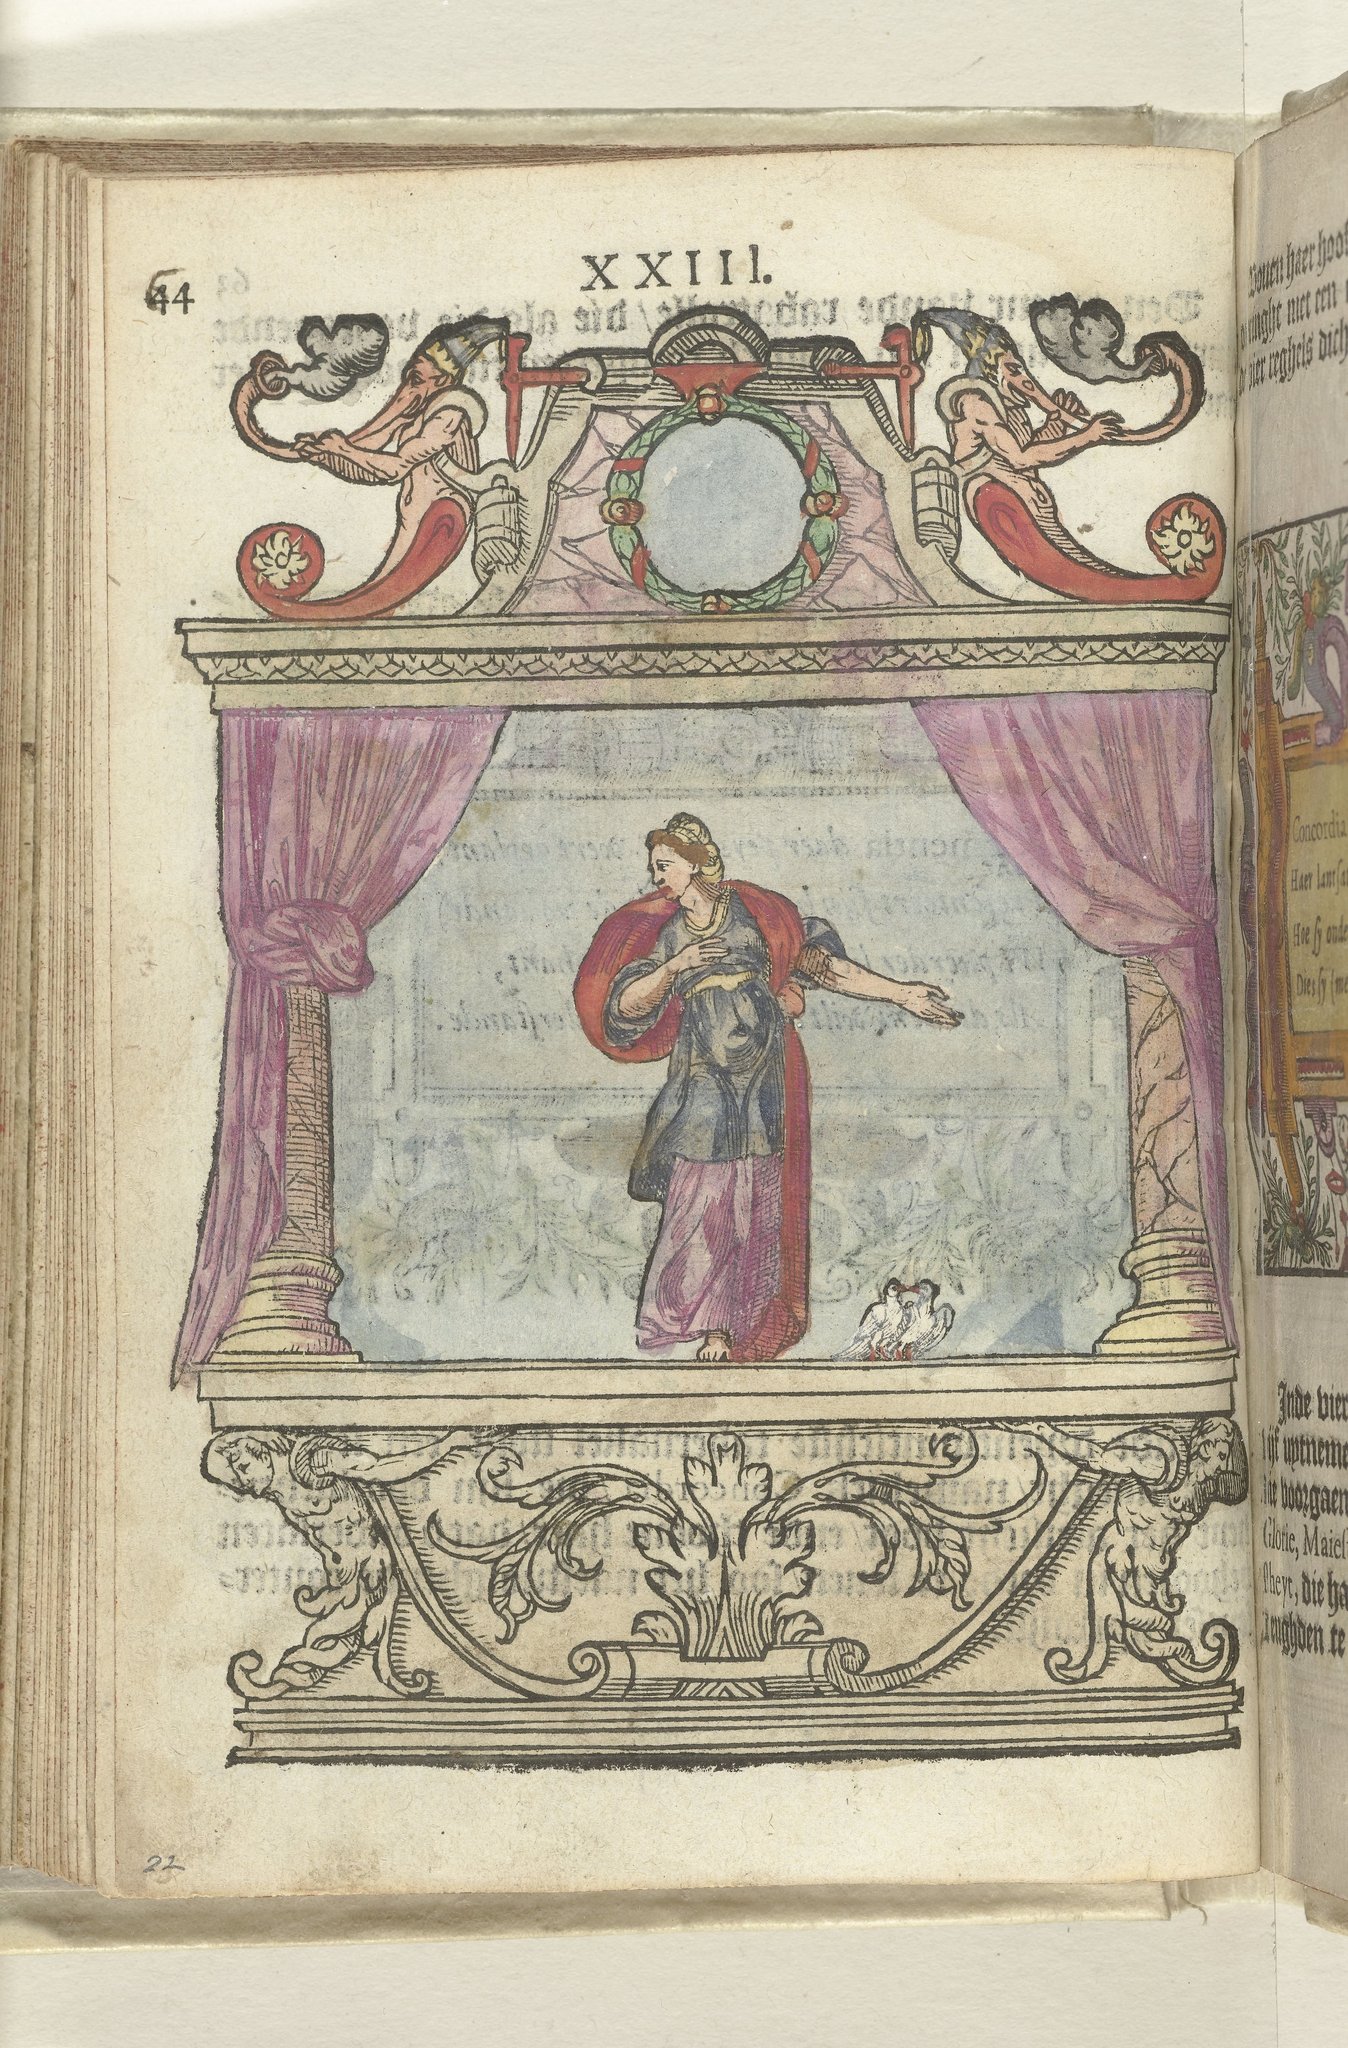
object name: print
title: Toneel met de personificatie van Eendracht (Concordia), 1578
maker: antoni van leest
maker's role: print maker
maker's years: 1545-1592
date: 1578-1579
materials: paper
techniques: hand coloring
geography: antwerp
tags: matthias van oostenrijk (rooms-duits keizer), agreement, unity; 'concordia', 'concordia insuperabile', 'concordia militare', 'concordia di pace', 'unione civile' (ripa), group of actors, troupe; actors on the stage, triumphal entry and public reception, pageant, 'entrée solennelle', 'joyeuse entrée', brussels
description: Illustratie in: J.B. Houwaert, Sommare beschrijvinghe vade triumphelijcke Incomst van den doorluchtighen ende hooghgheboren /Aerts-hertoge Matthias binnen die Prinelijcke stadt van Brussele, in 't iaer ons Heeren 1578 den XVIII dach Januarij... Gheinventeert ende ghecomponeert deur Jean Baptista Houwaert, Christoffel Plantijn, Antwerpen 1579. Boek in de Rijksmuseum Research Library met signatuur: 327 K 2.